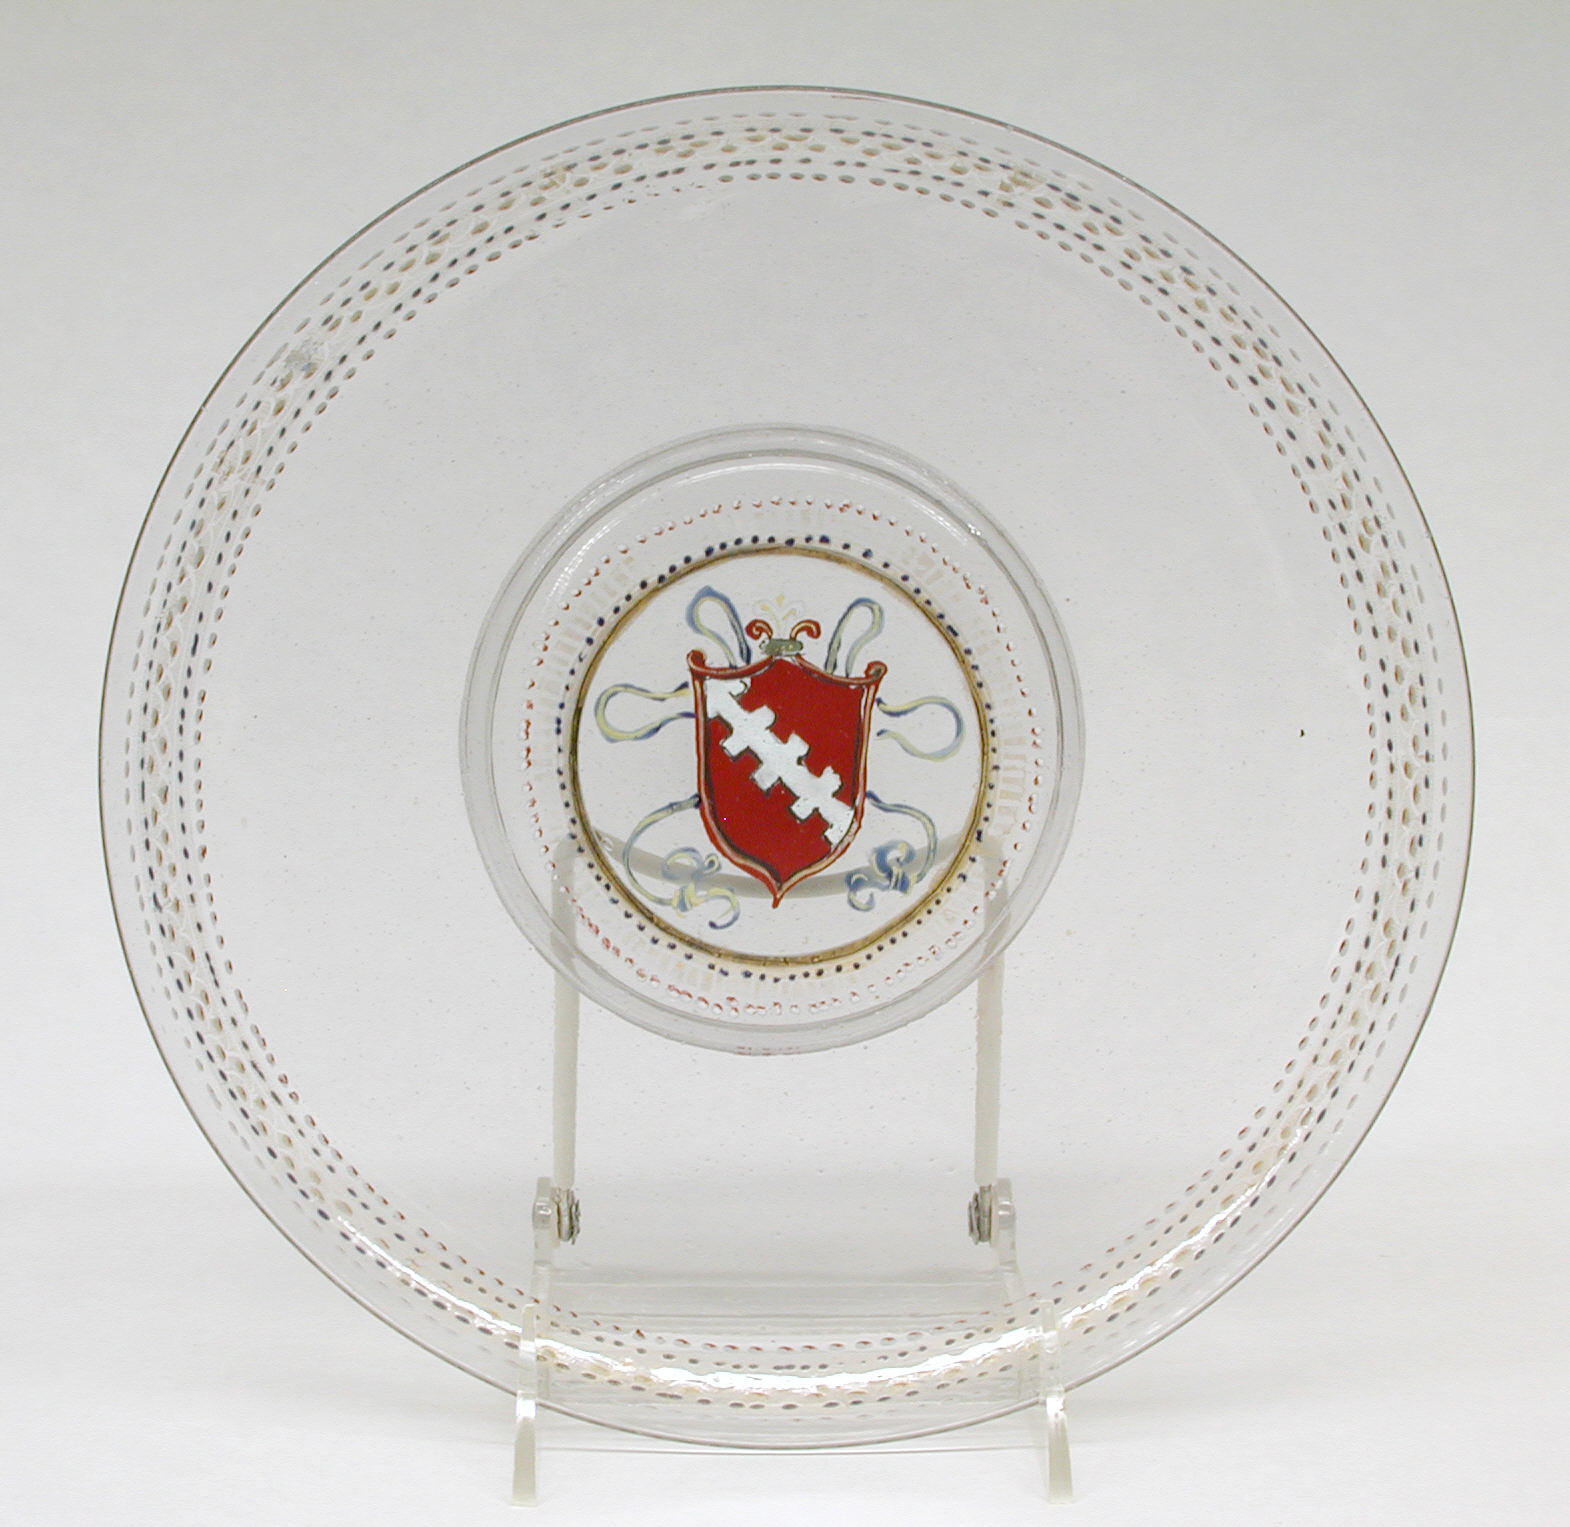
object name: tazza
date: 1501-1600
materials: glass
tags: coat of arms